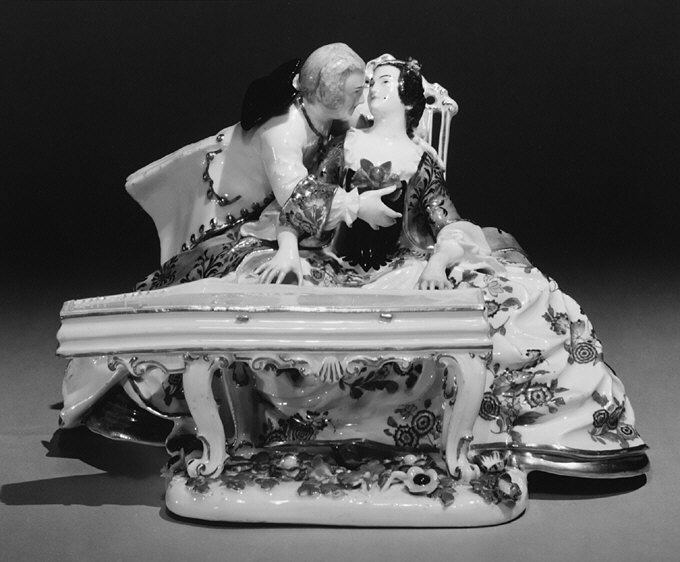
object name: group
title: Lovers at a spinet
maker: meissen manufactory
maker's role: manufactory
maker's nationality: german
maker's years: 1710-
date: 1741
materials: hard paste porcelain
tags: musical instruments,men,lovers,women